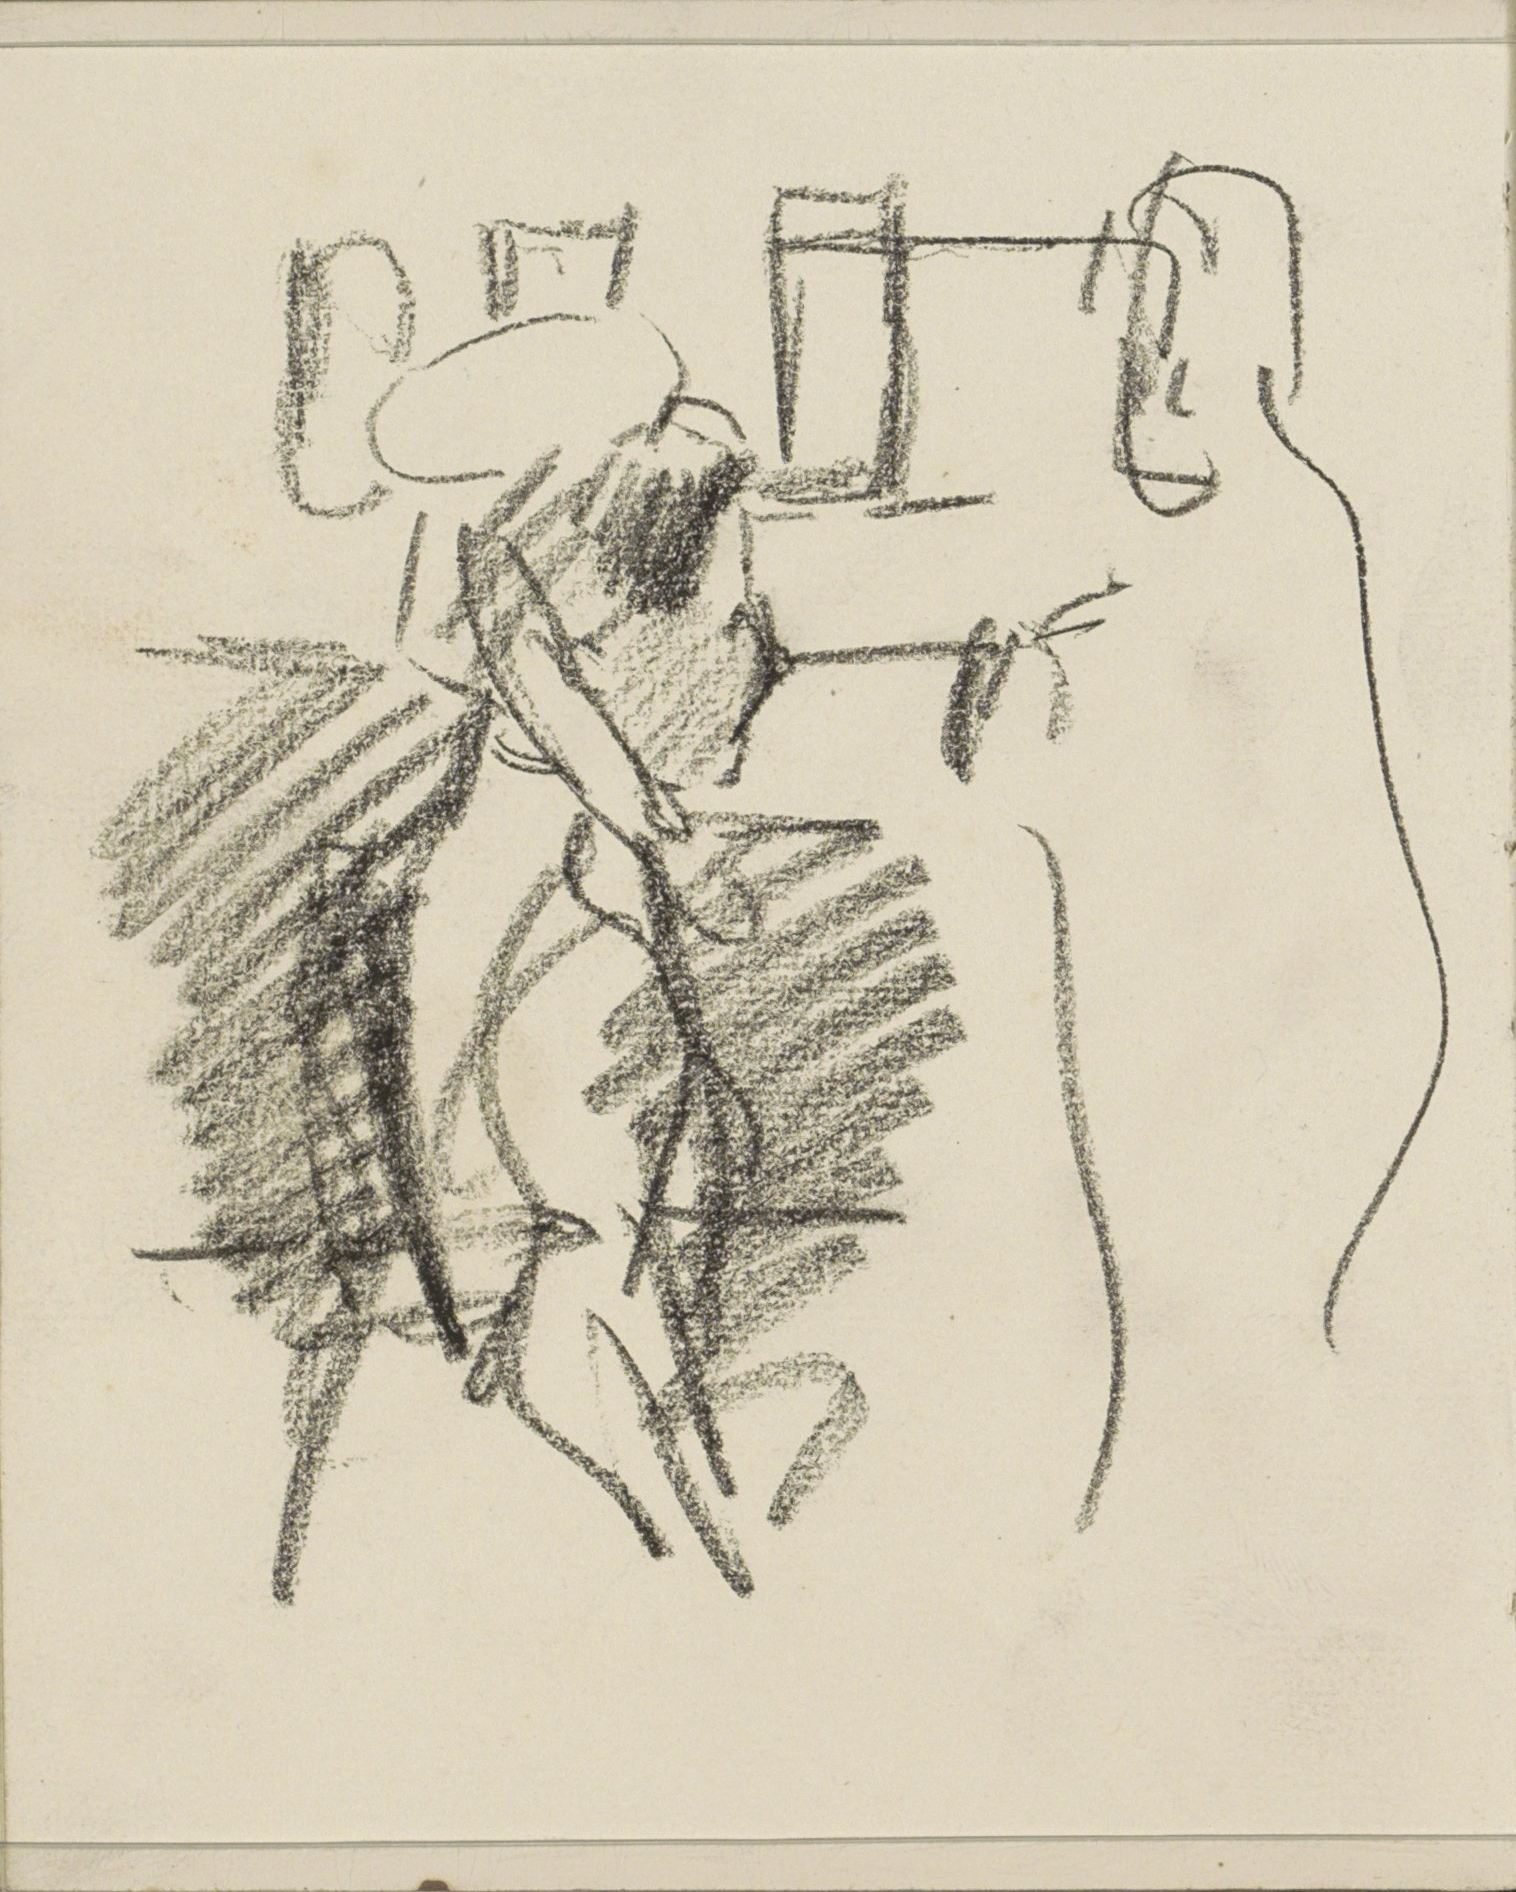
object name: sketchbook leaf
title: Dienstmeid op straat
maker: isaac israels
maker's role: draughtsman, painter, print maker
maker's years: 1865-1934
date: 1886-1903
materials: chalk, paper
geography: amsterdam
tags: maid ~ house personnel, street (+ city(-scape) with figures, staffage)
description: Pagina 58 uit schetsboek XXXII met 92 pagina's.